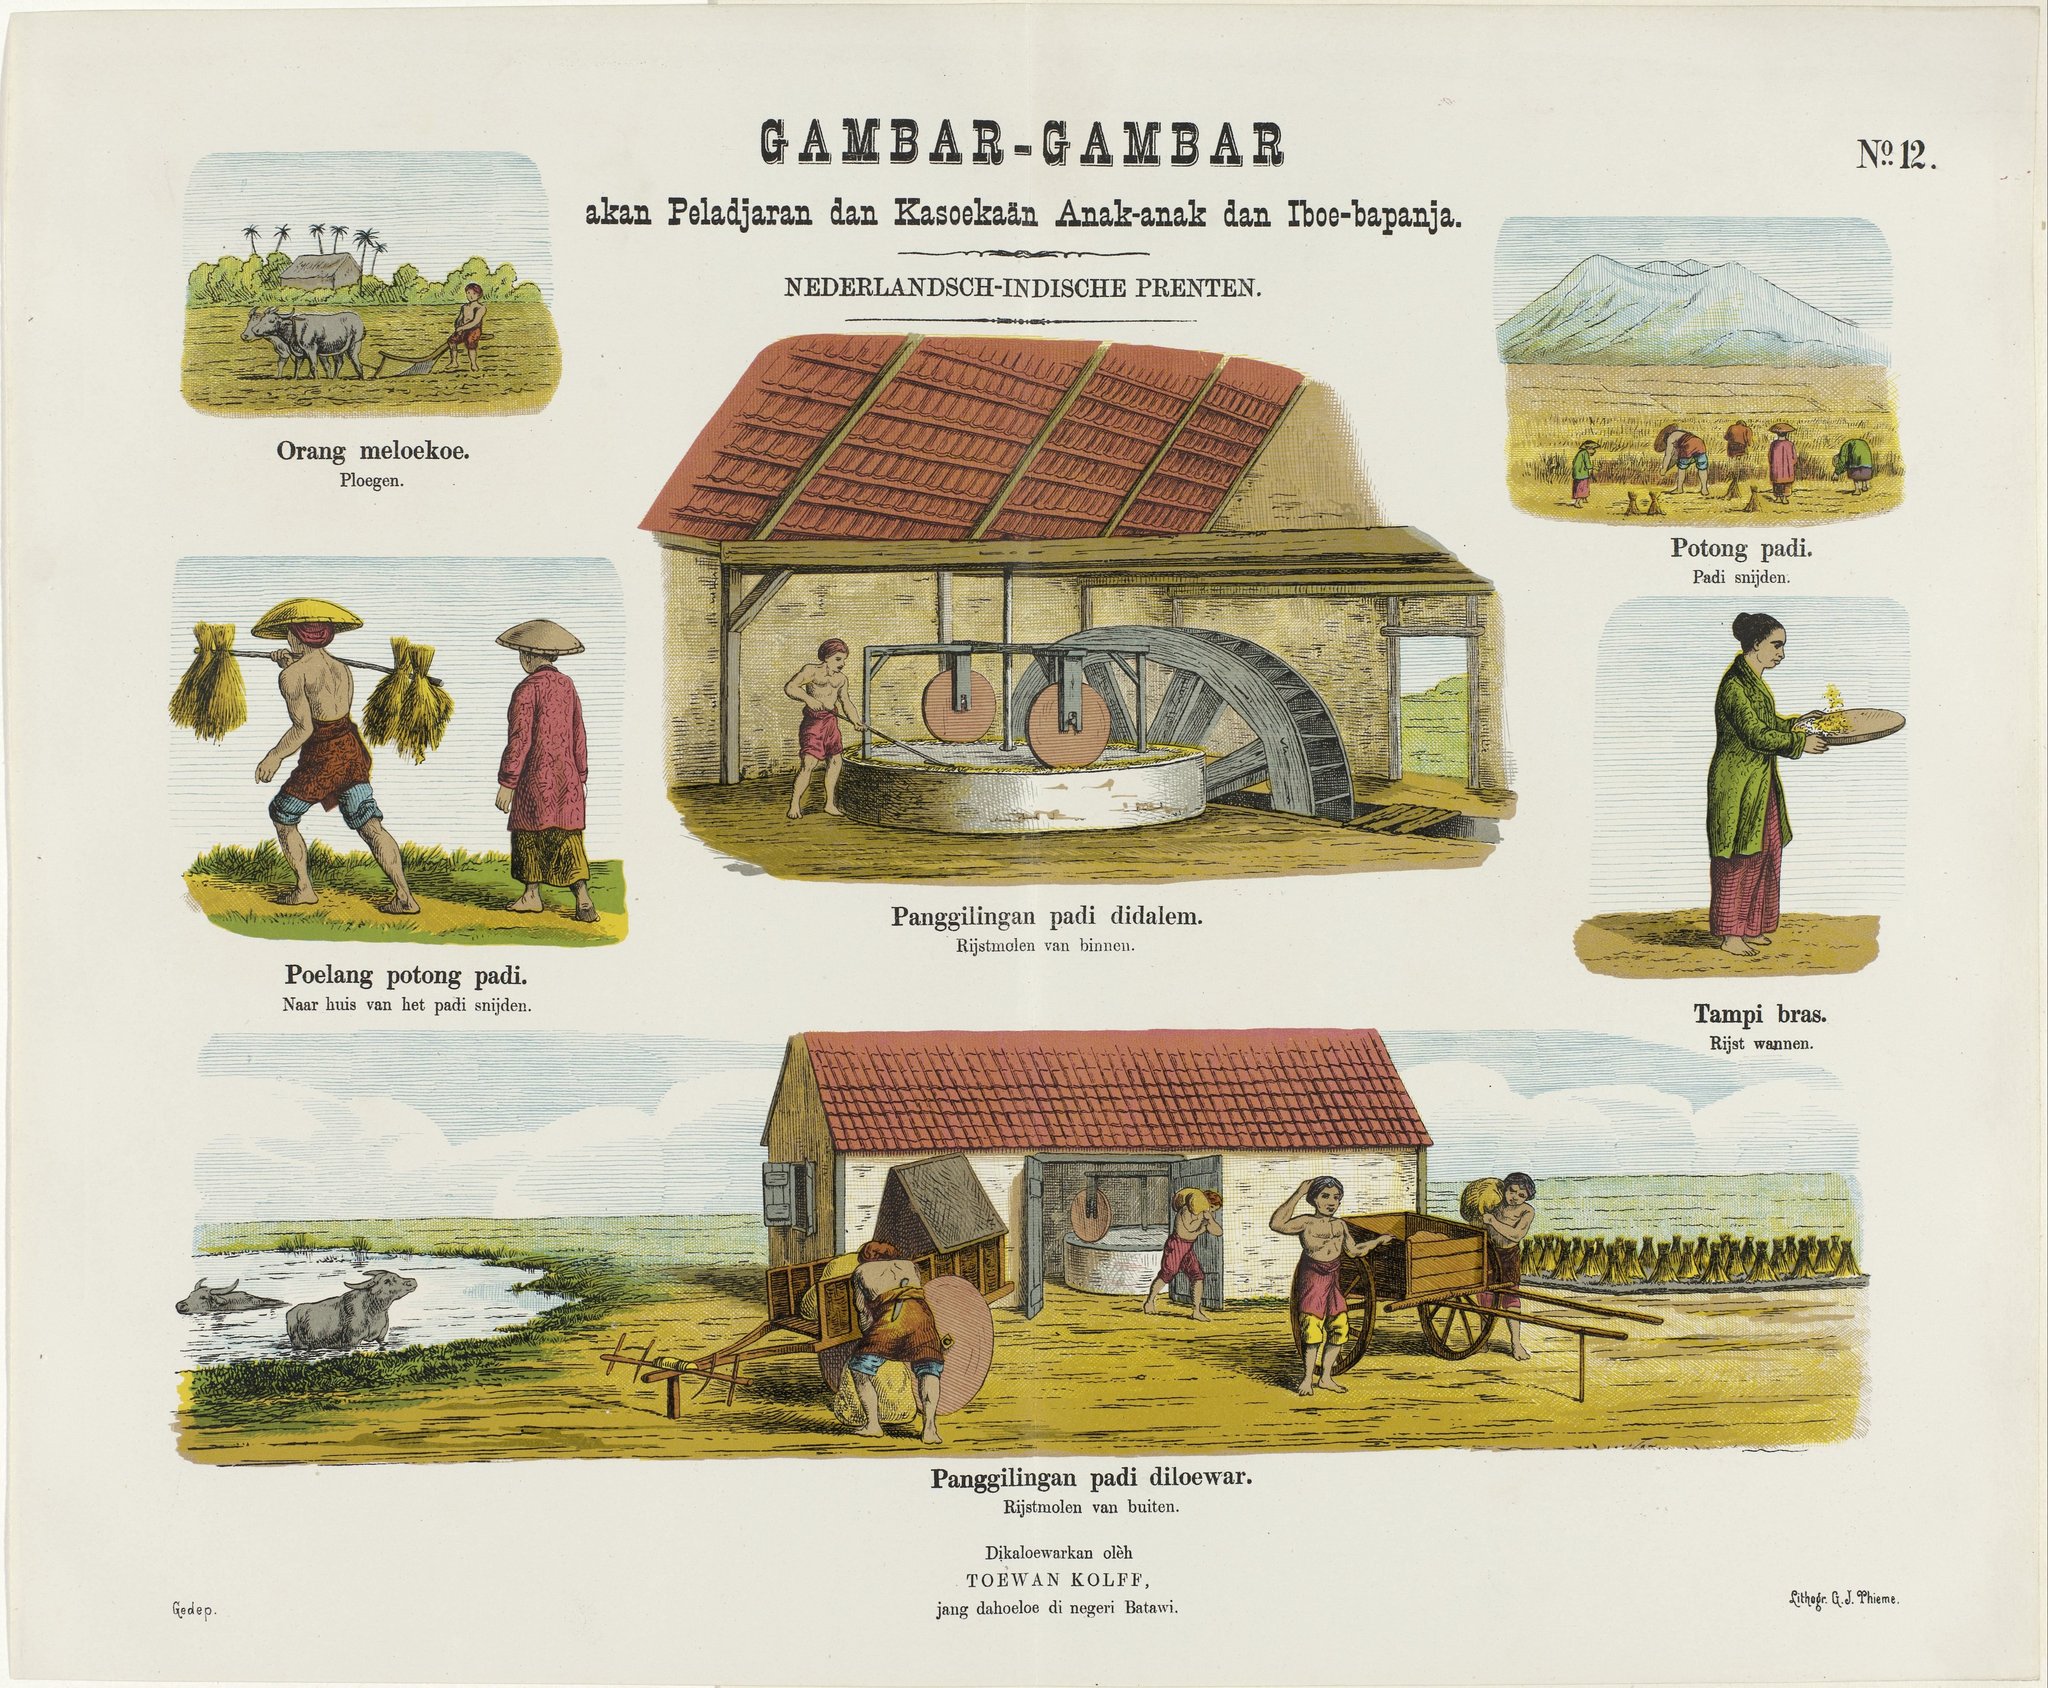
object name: popular print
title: Rijstproductie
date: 1868-1881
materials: paper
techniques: lithograph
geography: netherlands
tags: asiatic races and peoples, cereal, grain, corn (grass with grains, grown for food, e.g.: wheat, rice, rye, oats, maize, buckwheat, millet), sawahs, rice paddies, dutch east indies, the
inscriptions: collector's mark: Lugt 2760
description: Blad met zes voorstellingen over de productie van rijst in de voormalige kolonie Nederlands-Indië. Onder elke afbeelding een onderschrift in het Maleis en het Nederlands. Genummerd rechtsboven: No. 12.